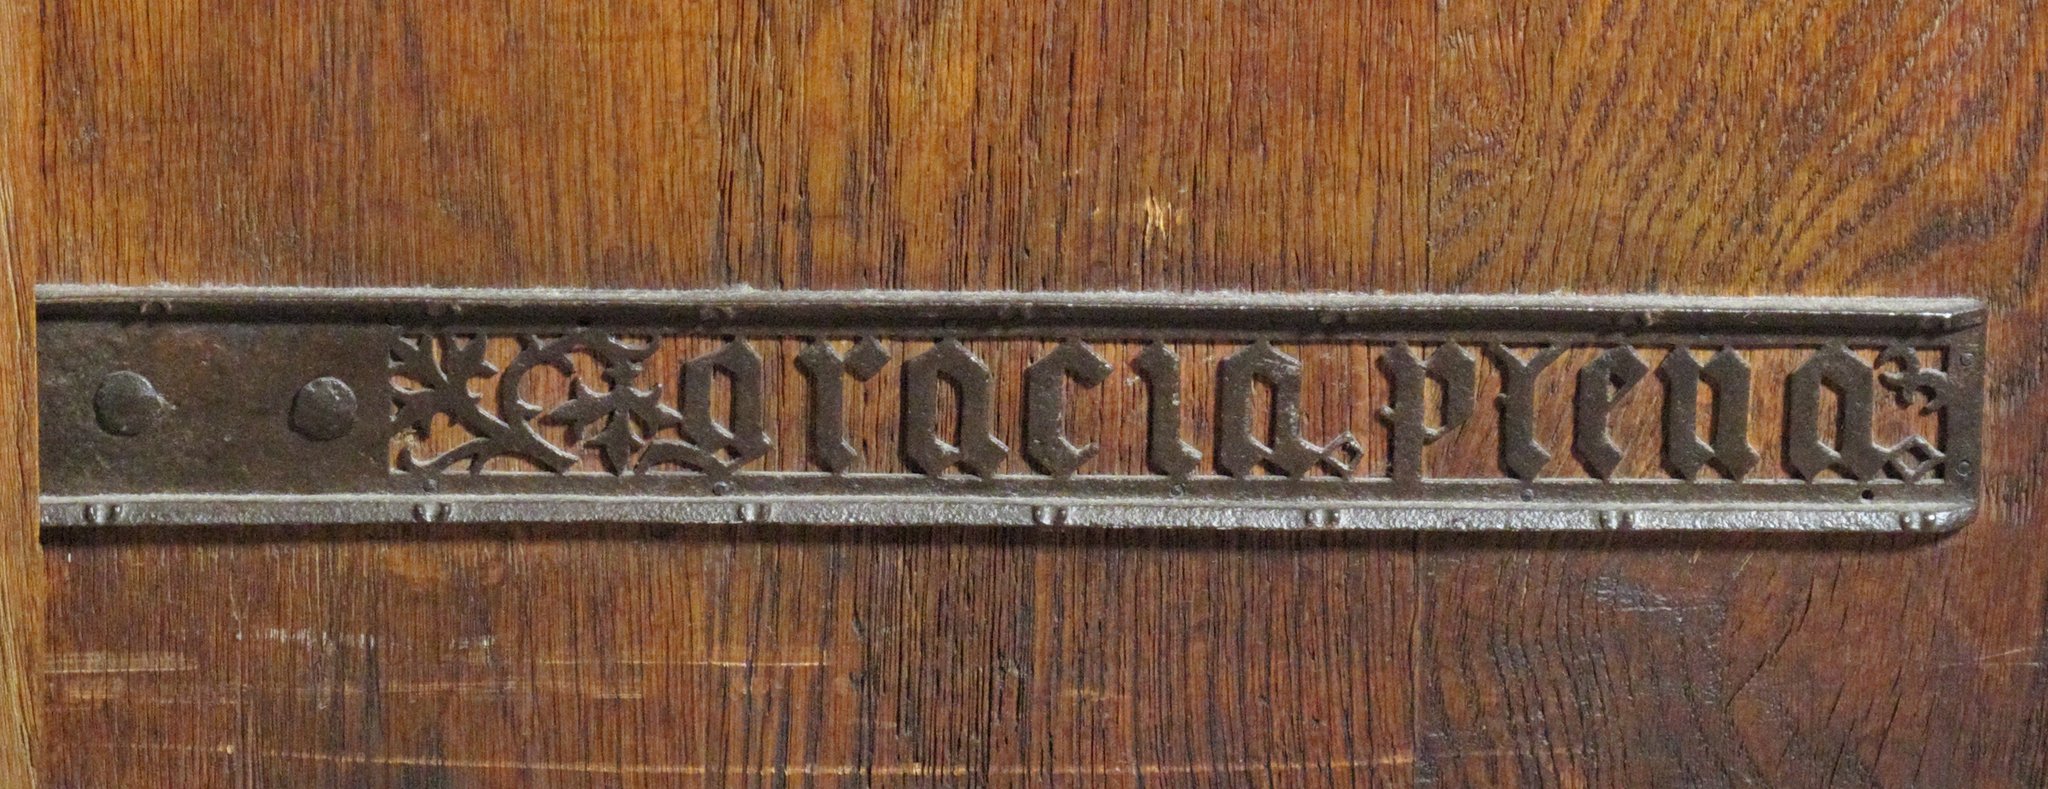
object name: hinge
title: Hinges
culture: spanish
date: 1401-1500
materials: iron